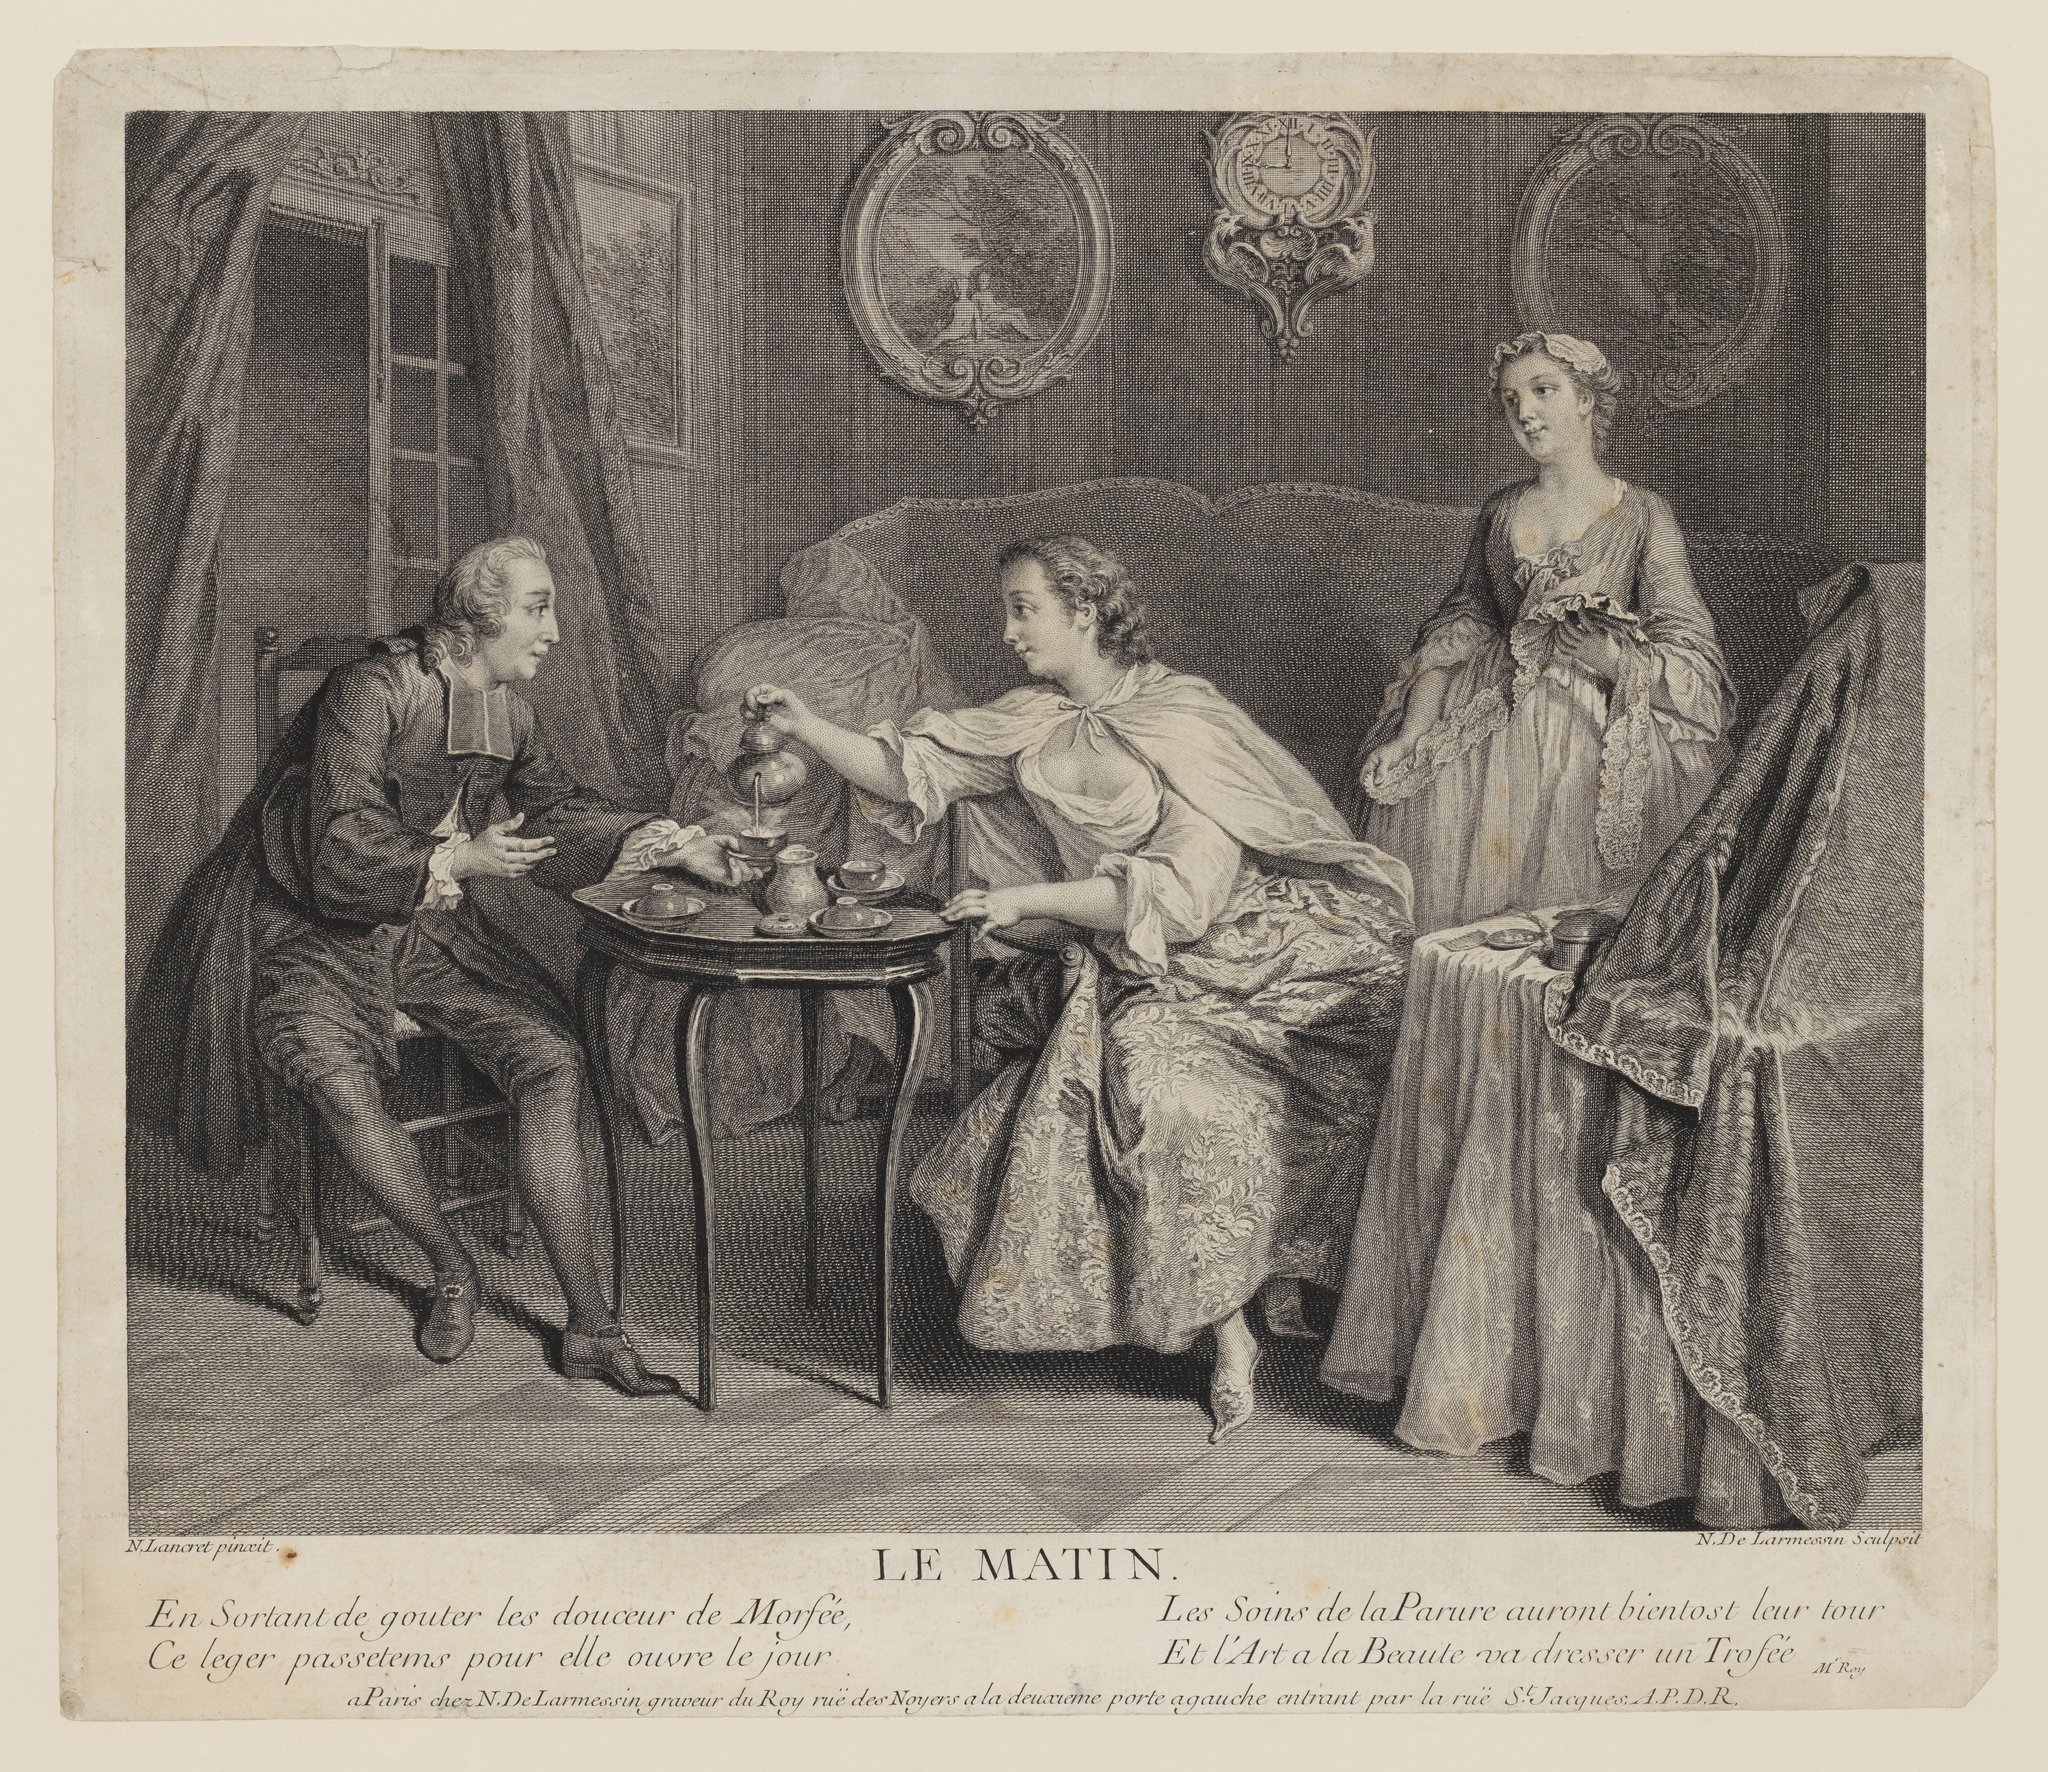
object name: print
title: Le Matin (Morning)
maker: nicolas de larmessin iii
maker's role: engraver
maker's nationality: french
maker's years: 1685-1755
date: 1741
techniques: engraving, etching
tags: men,women,tea drinking,tables,tea